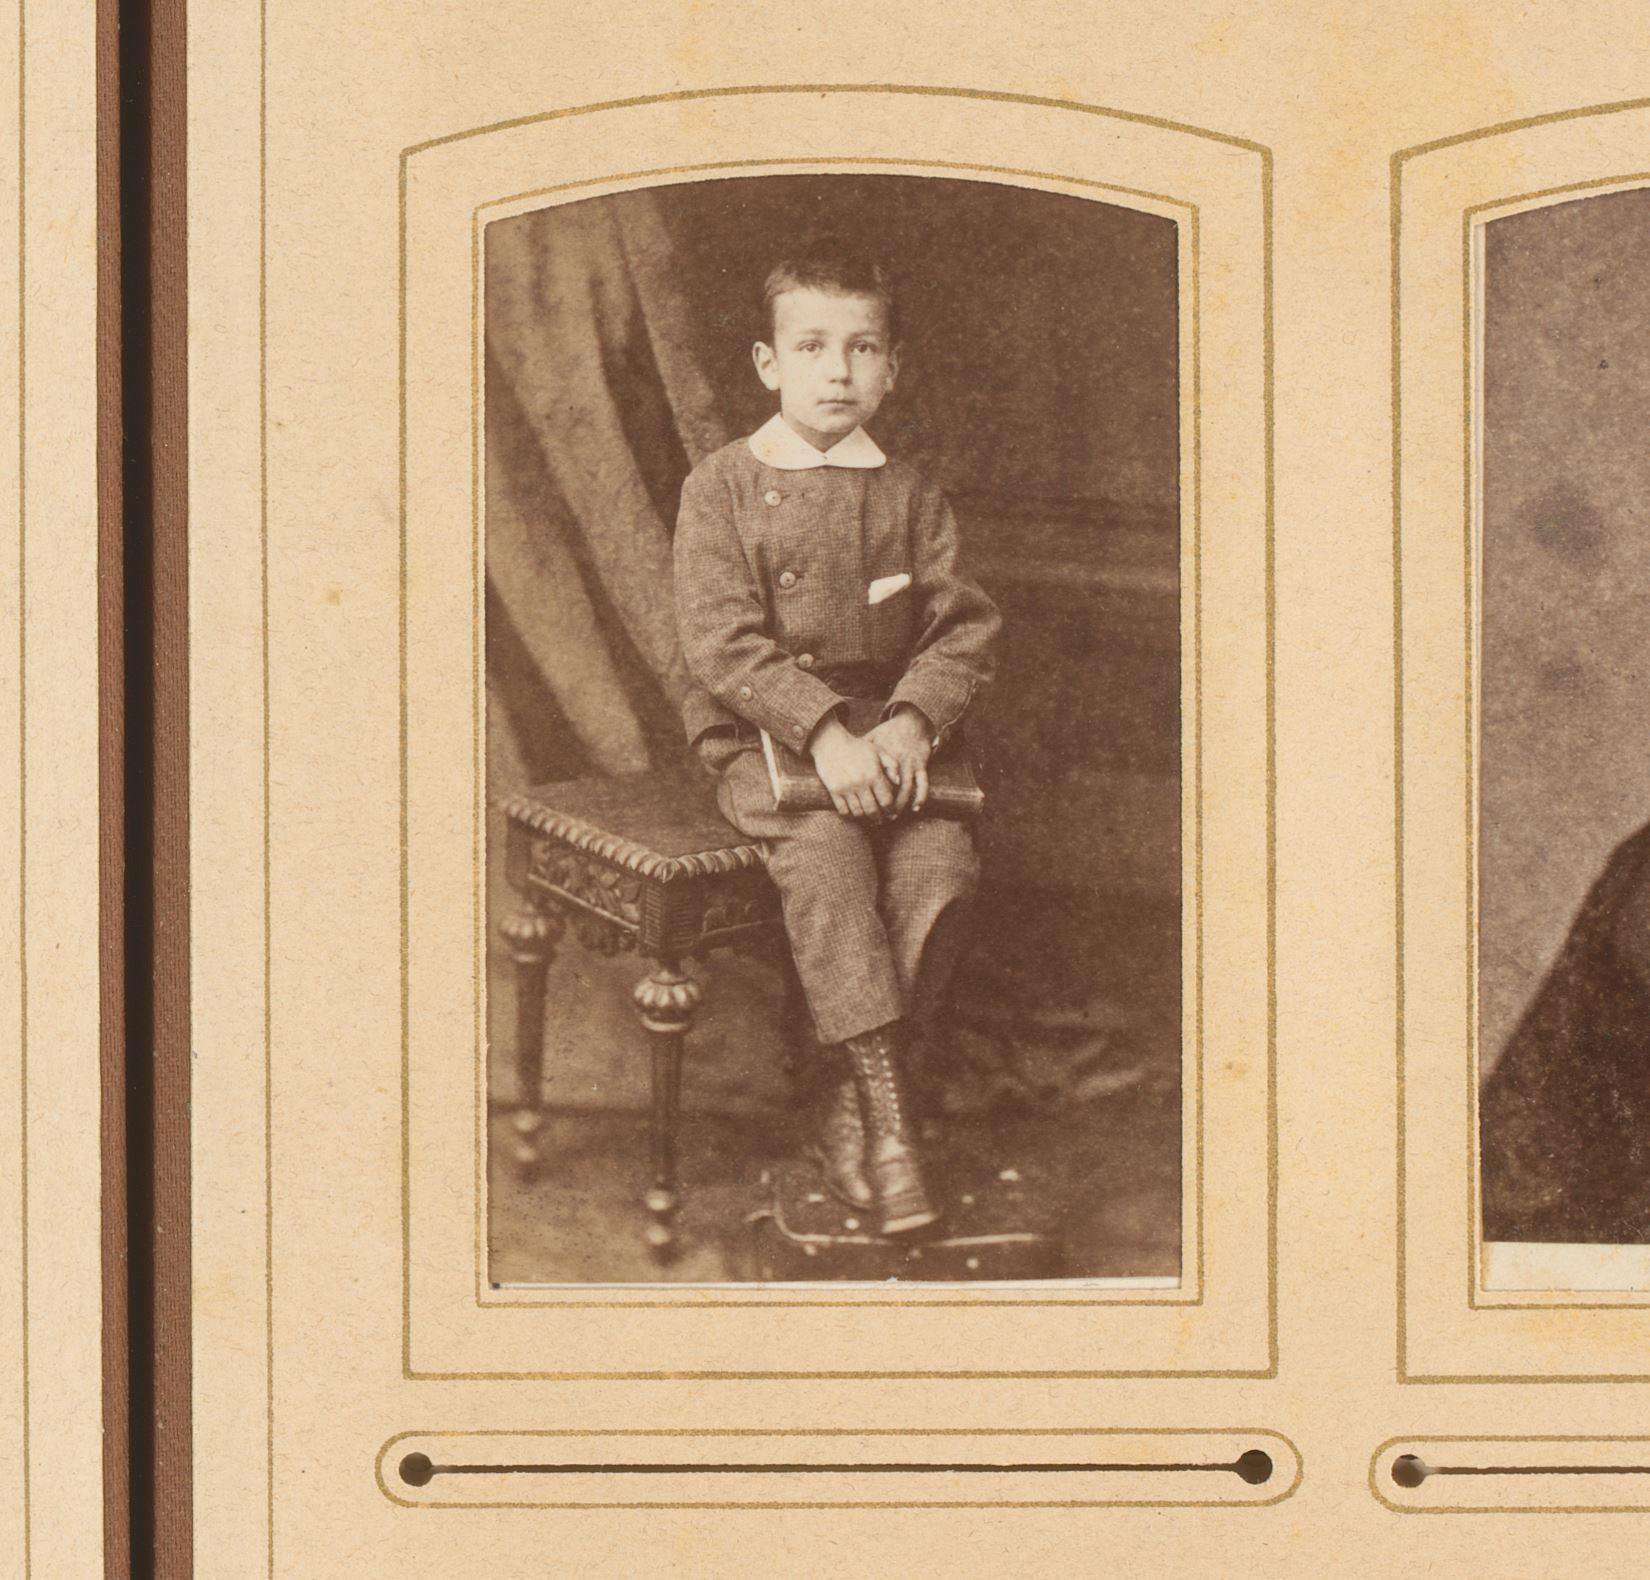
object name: carte de visite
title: Portret van een jongen met boek op schoot, zittend op een tafel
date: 1860-1884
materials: cardboard, photographic support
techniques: albumen print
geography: amsterdam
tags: sitting figure, historical persons, table, book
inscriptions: inscription: ‘Photographisch Artistisch Atelier/ van/ Wegner & Mottu/ Amsterdam/ Rokin over de Bank/ 138./ Utrecht/ Leijdschestraatweg/ 153./ Het cliché wordt voor verdere/ bestellingen bewaard.’